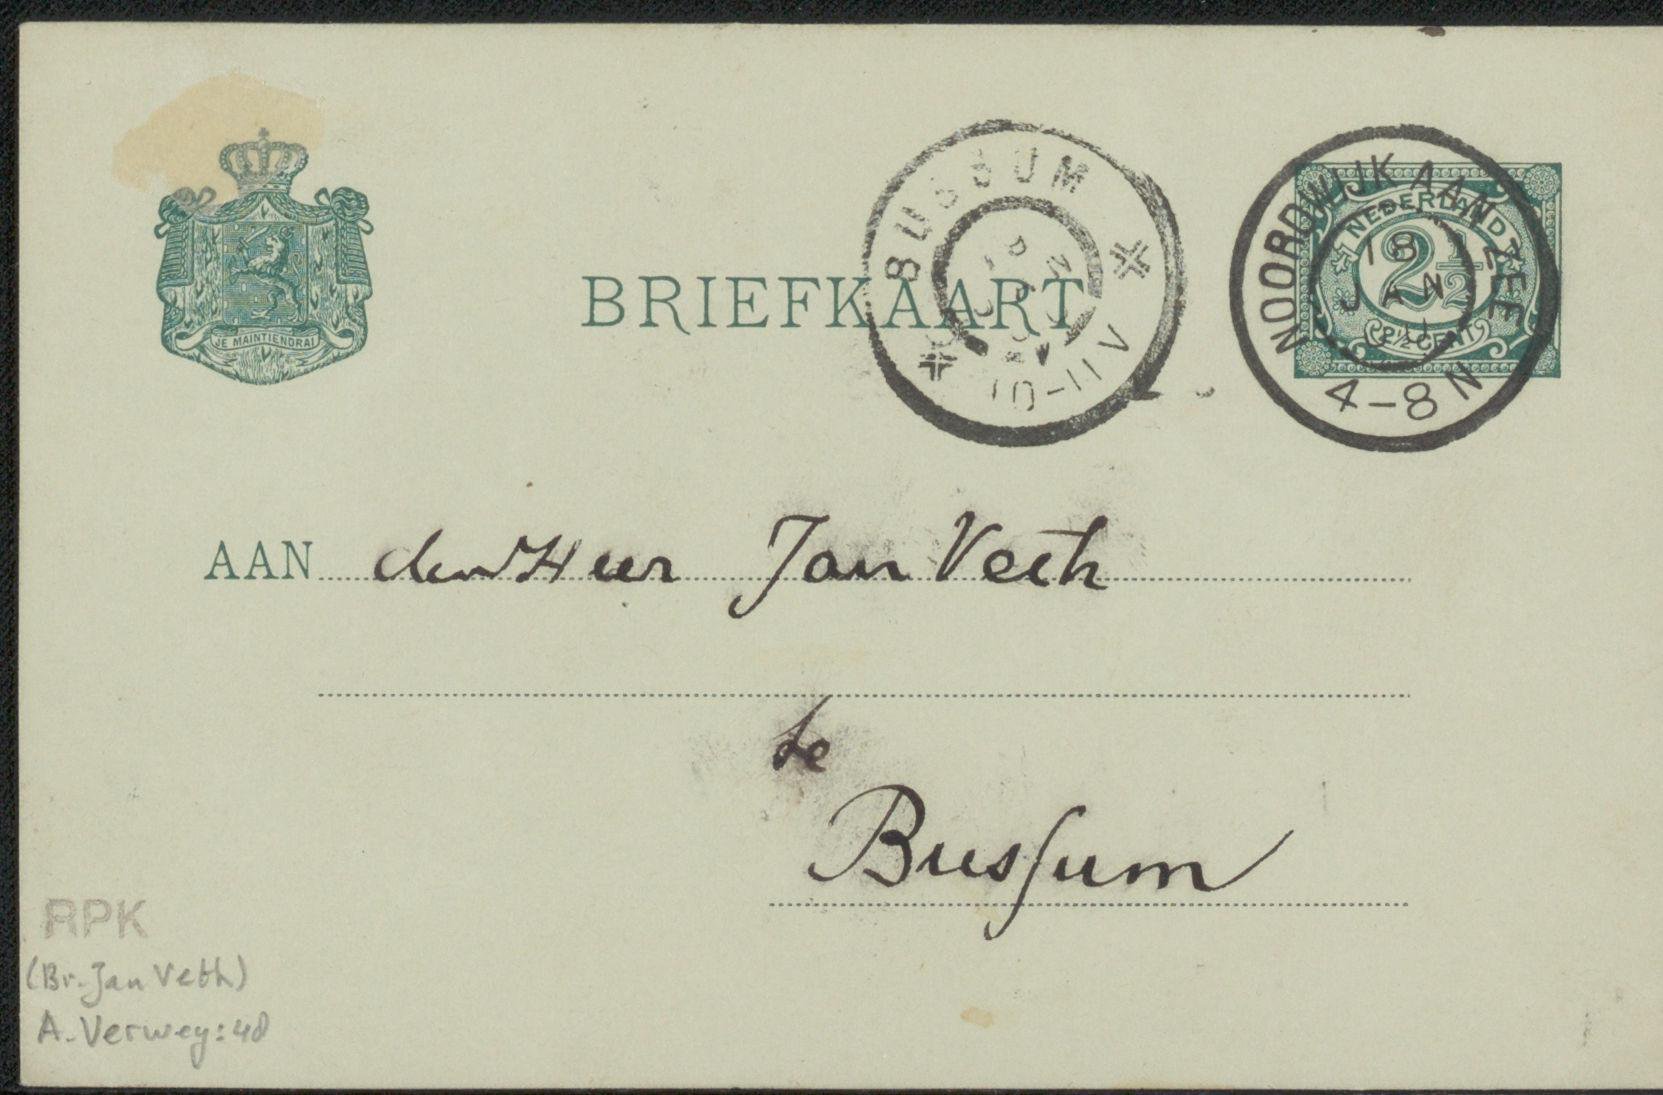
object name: postcard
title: Briefkaart aan Jan Veth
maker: albert verwey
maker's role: criticus, dichter, essayist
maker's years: 1865-1937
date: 1900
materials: cardboard, ink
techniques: pen, writing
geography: noordwijk aan zee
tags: painter, aert van der neer, dordrecht, print maker, draughtsman, designer, jan veth, literature ~ arts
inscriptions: collector's mark: ‘RPK’